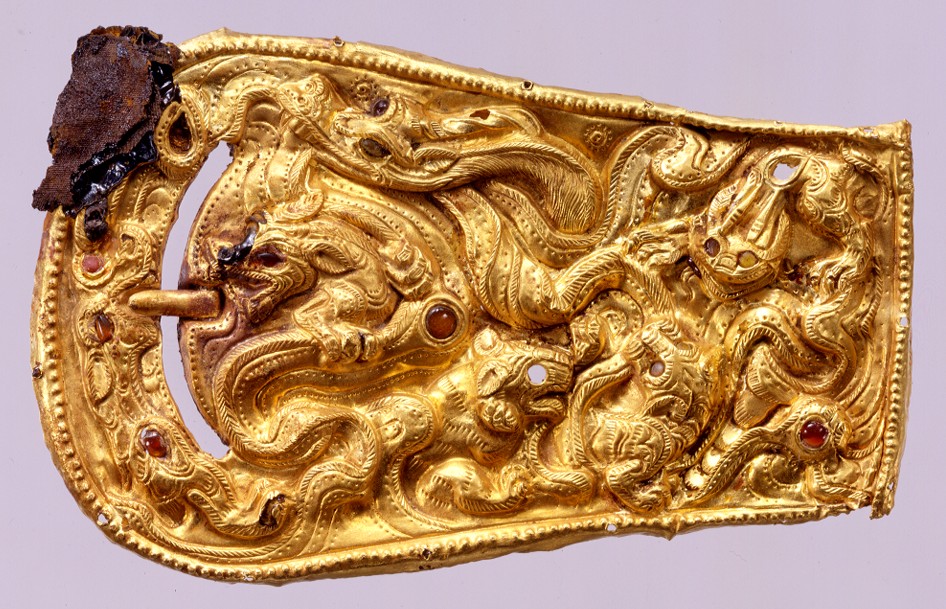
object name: belt buckle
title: Belt Buckle with Zoomorphic Motif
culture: north chinese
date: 1-200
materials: gemstone, glass, gold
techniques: inlay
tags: mythical creatures